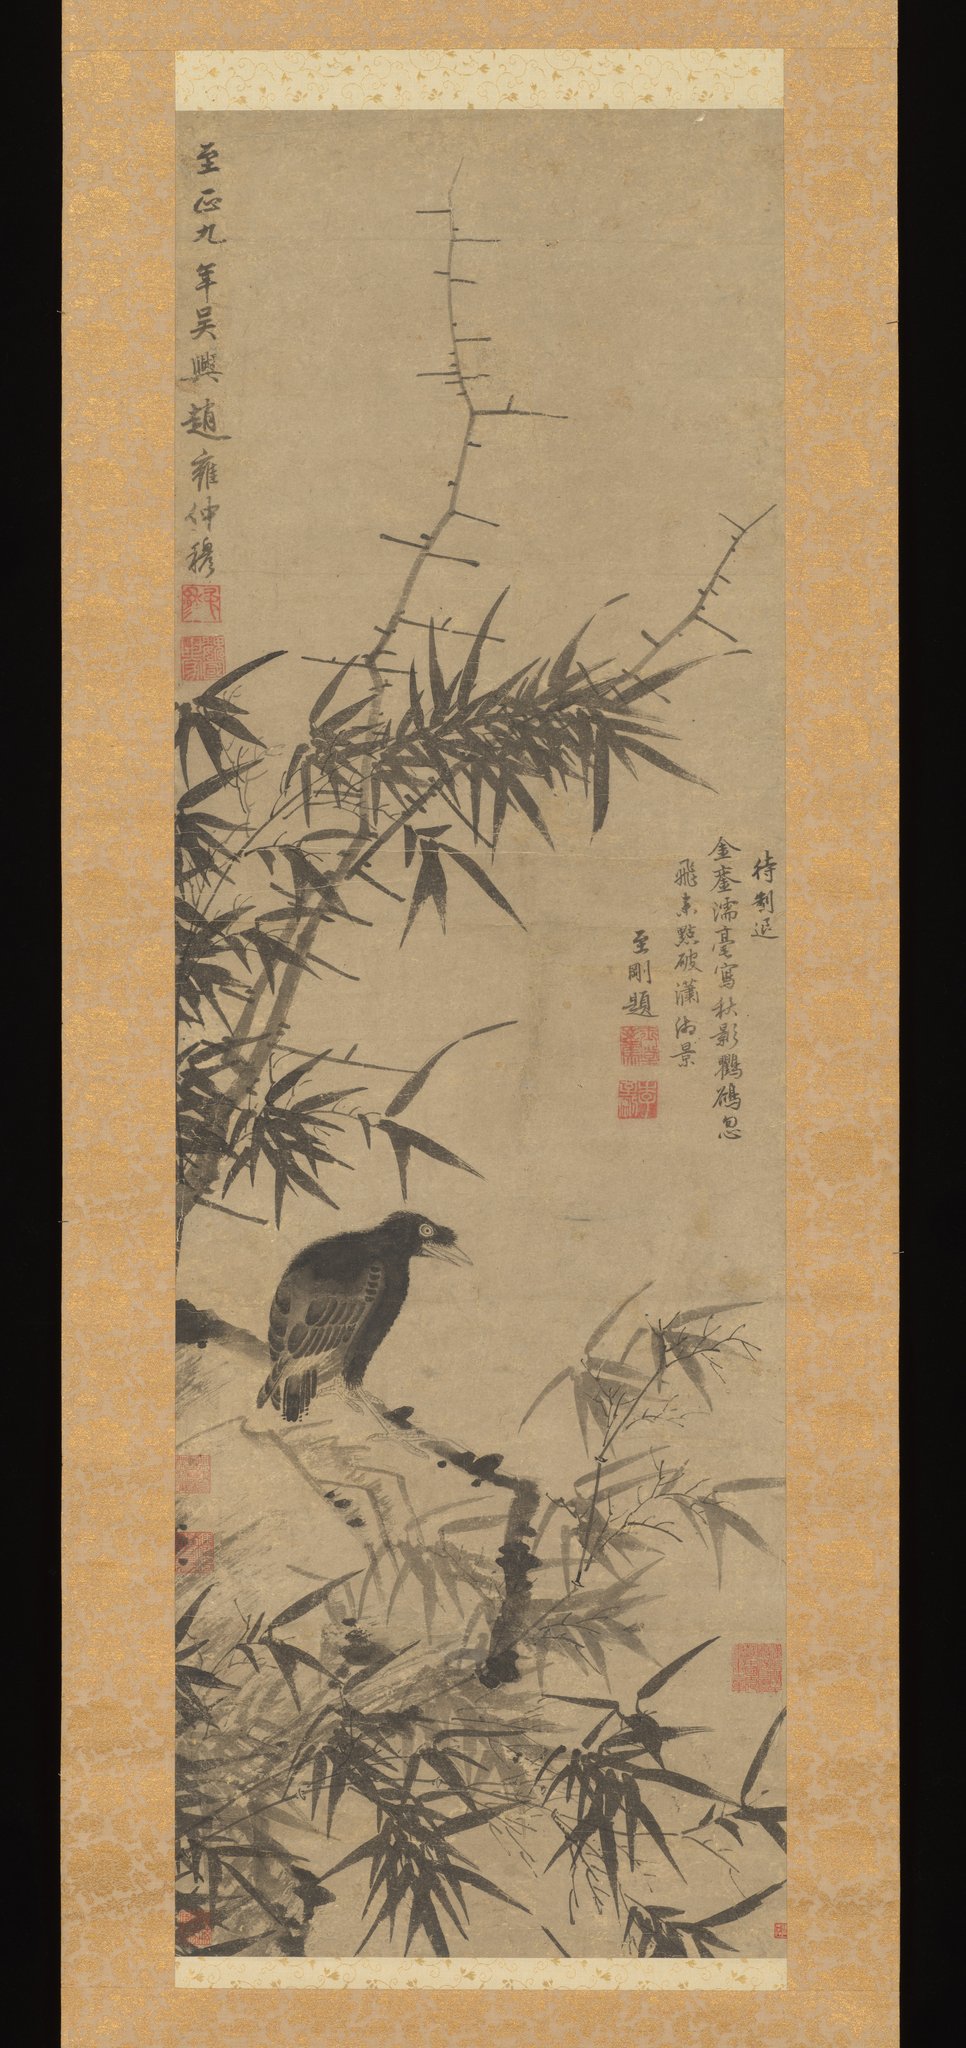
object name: hanging scroll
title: Mynah Bird and Bamboo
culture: chinese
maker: zhao yong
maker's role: artist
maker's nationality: chinese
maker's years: 1289-1360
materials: ink, paper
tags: birds,bamboo